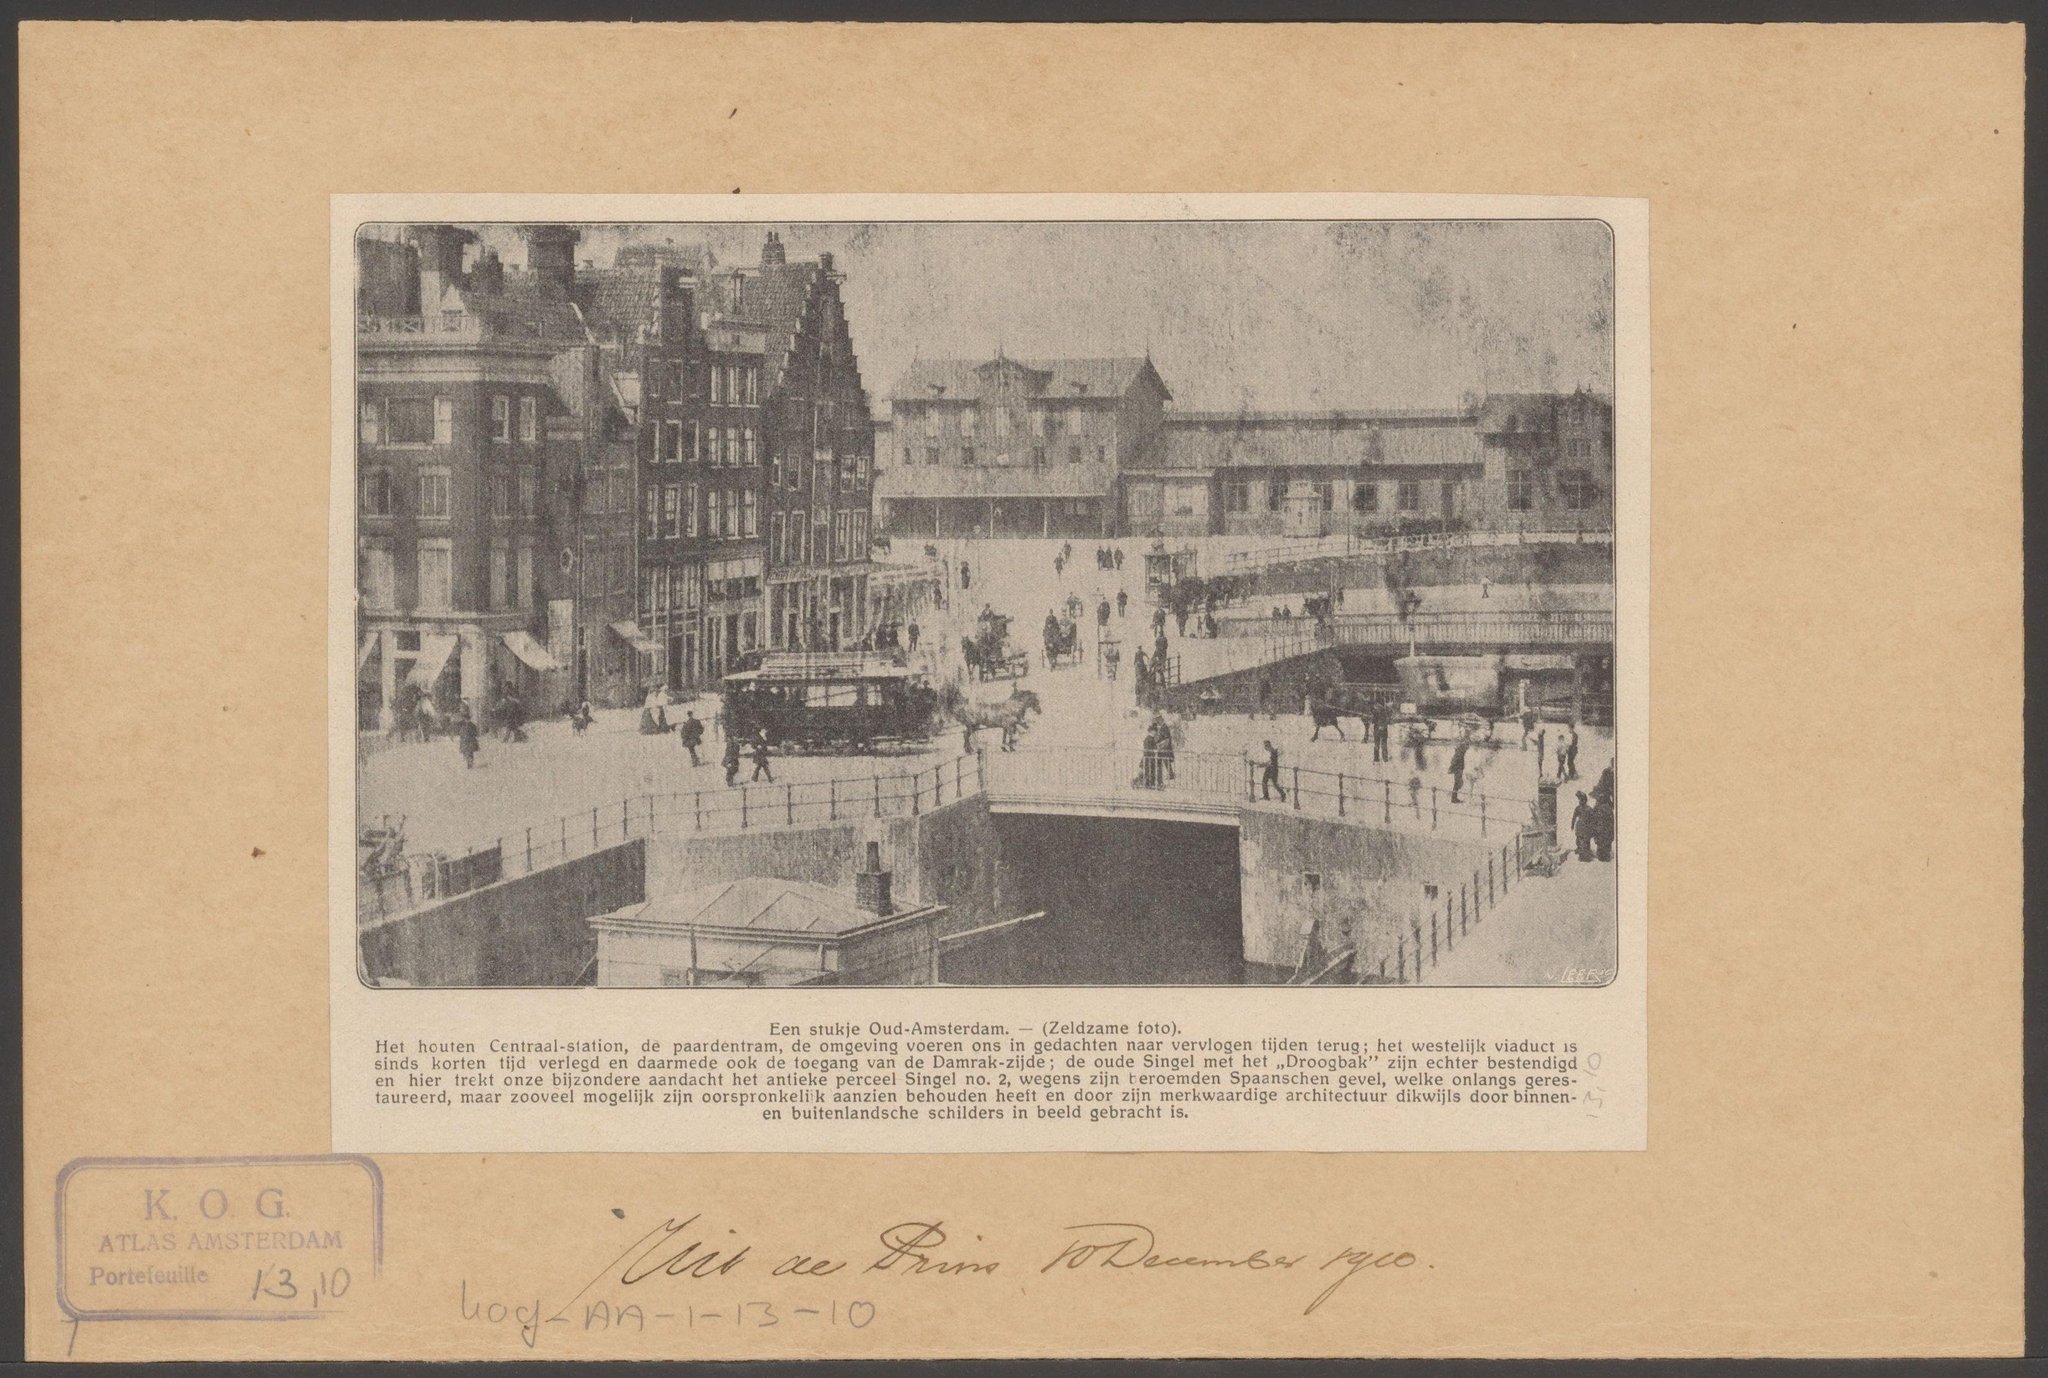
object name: photomechanical print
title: Gezicht op het Singel, hoek Droogbak met het Centraal Station Amsterdam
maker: Anonymous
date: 1910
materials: paper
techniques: letterpress printing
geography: amsterdam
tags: city-view in general; 'veduta', canal, bridge in city across river, canal, etc., street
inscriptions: collector's mark: ‘13,10’ Lugt 1641b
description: Onderwerpsrubriek binnen de Atlas Amsterdam: Oude Schans, Schoutensteeg, Singel (Korte), Singel.